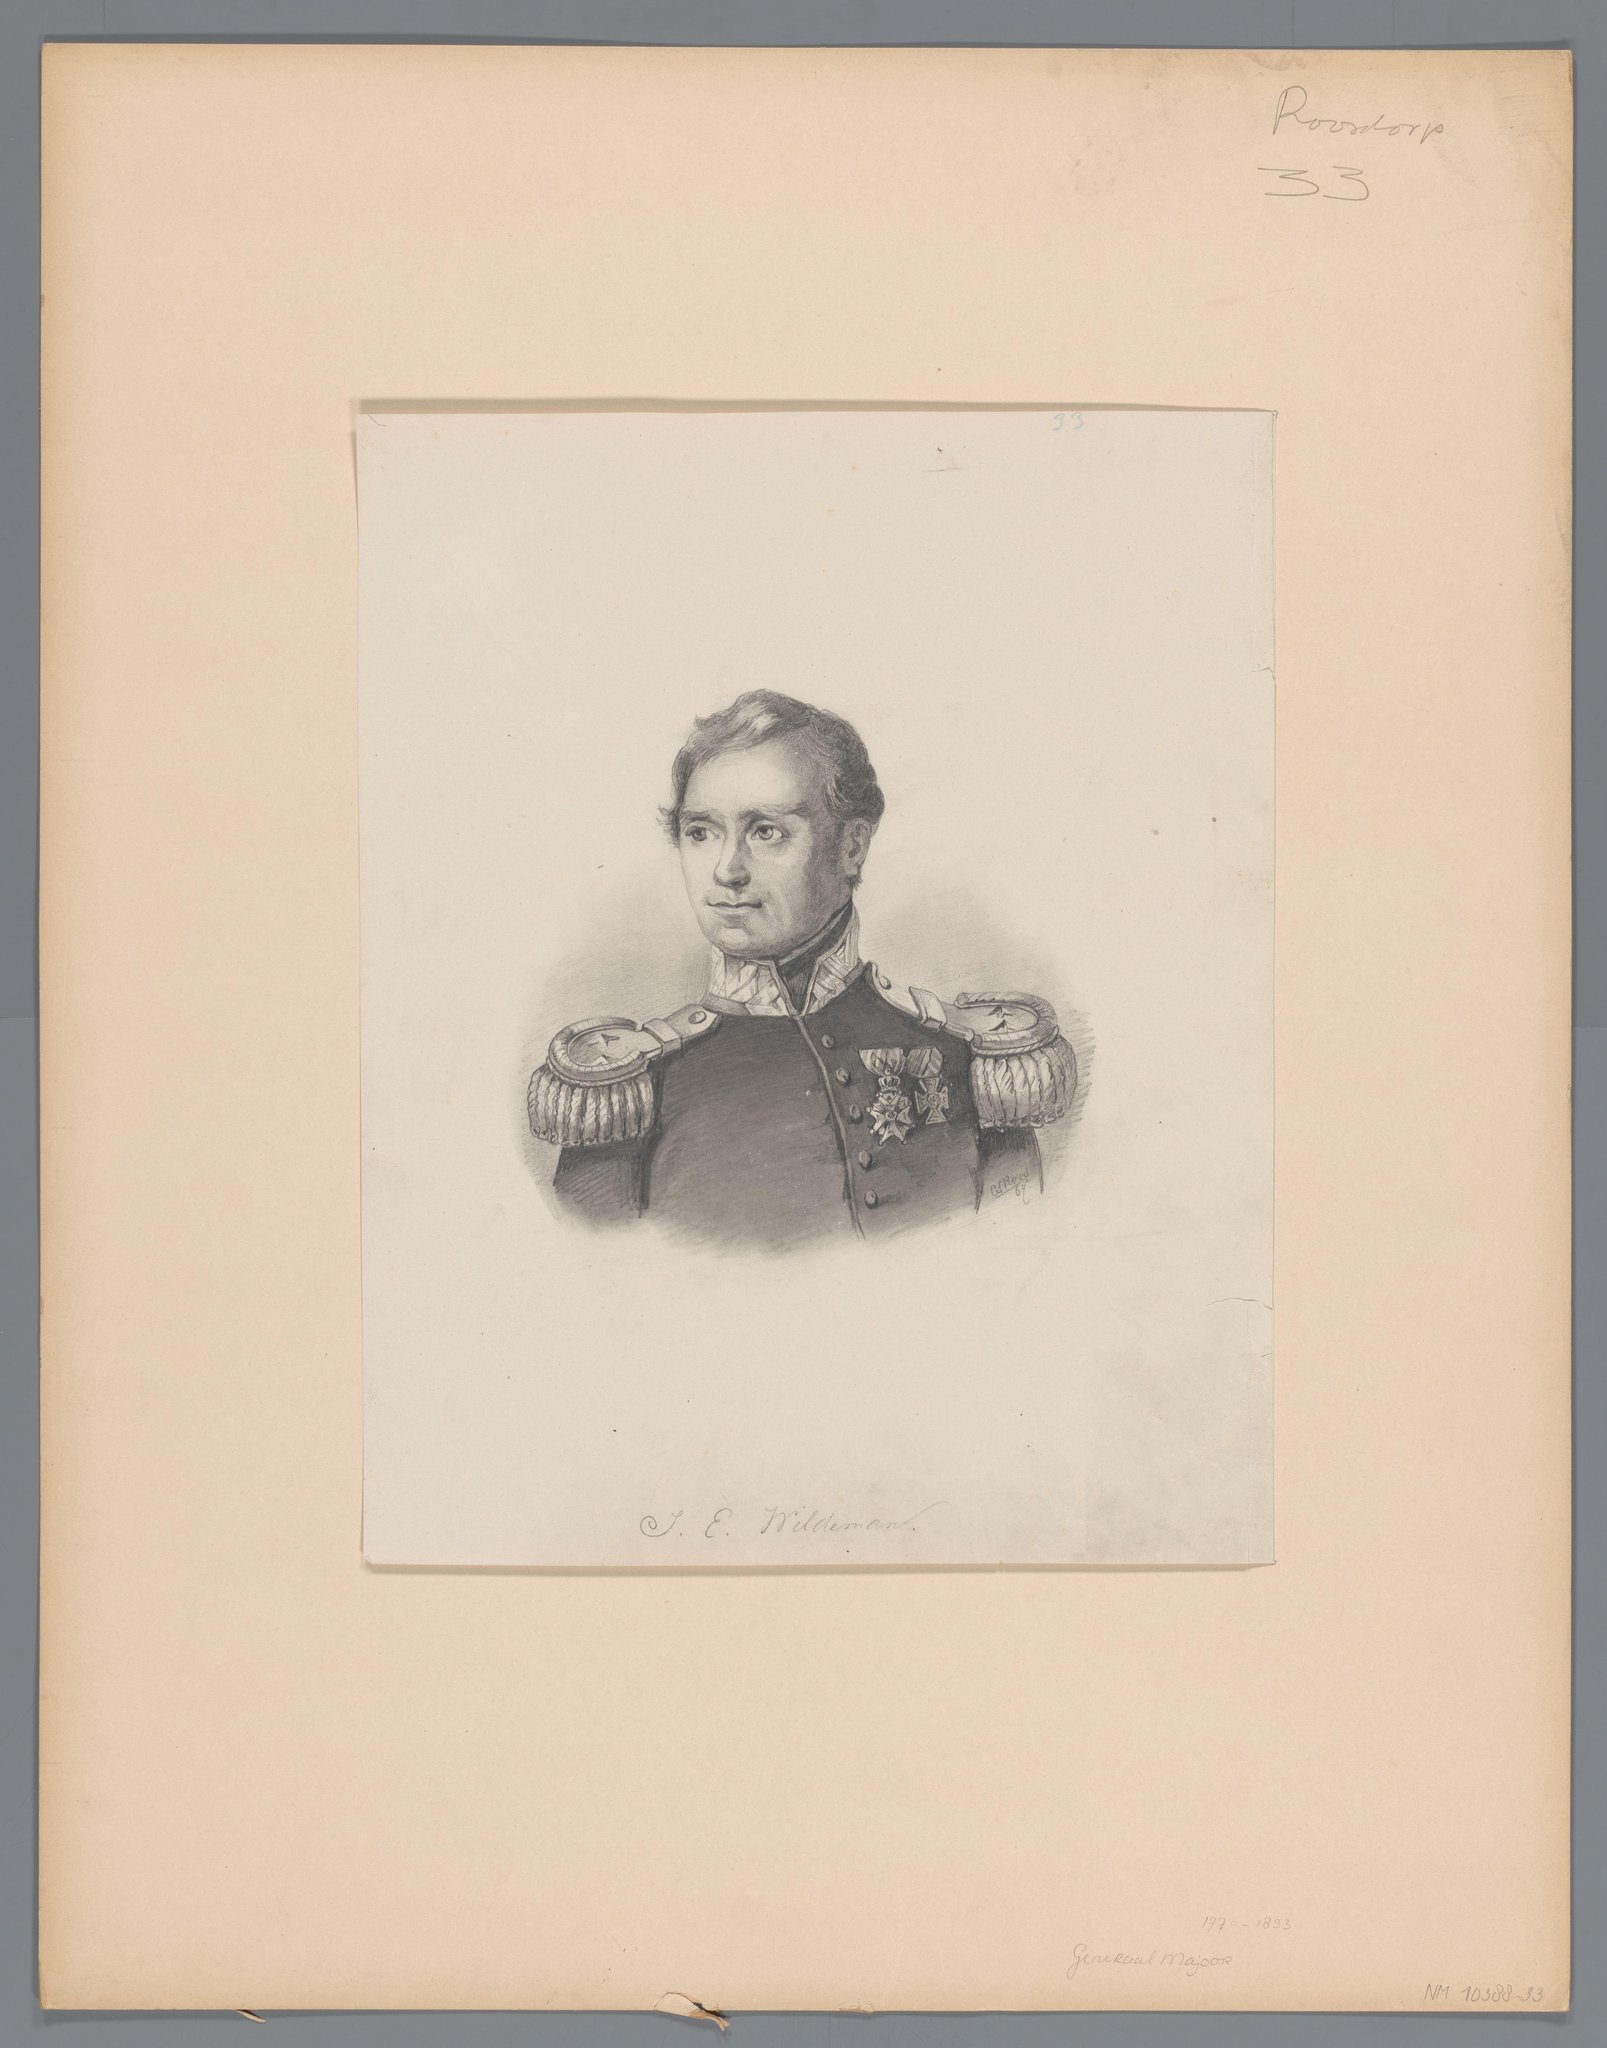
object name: drawing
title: Portret van generaal-majoor J.E. Wildeman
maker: cornelis sebille roos (uitgever)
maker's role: auctioneer, draughtsman, publisher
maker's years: 1754-1820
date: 1867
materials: paper, pencil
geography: netherlands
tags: harlingen, historical persons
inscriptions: signature and date: ‘C.S. Roos 67’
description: Portret van generaal-majoor Jan Ernst Wildeman, buste, gezicht naar links, in uniform met twee onderscheidingstekenen op de borst.